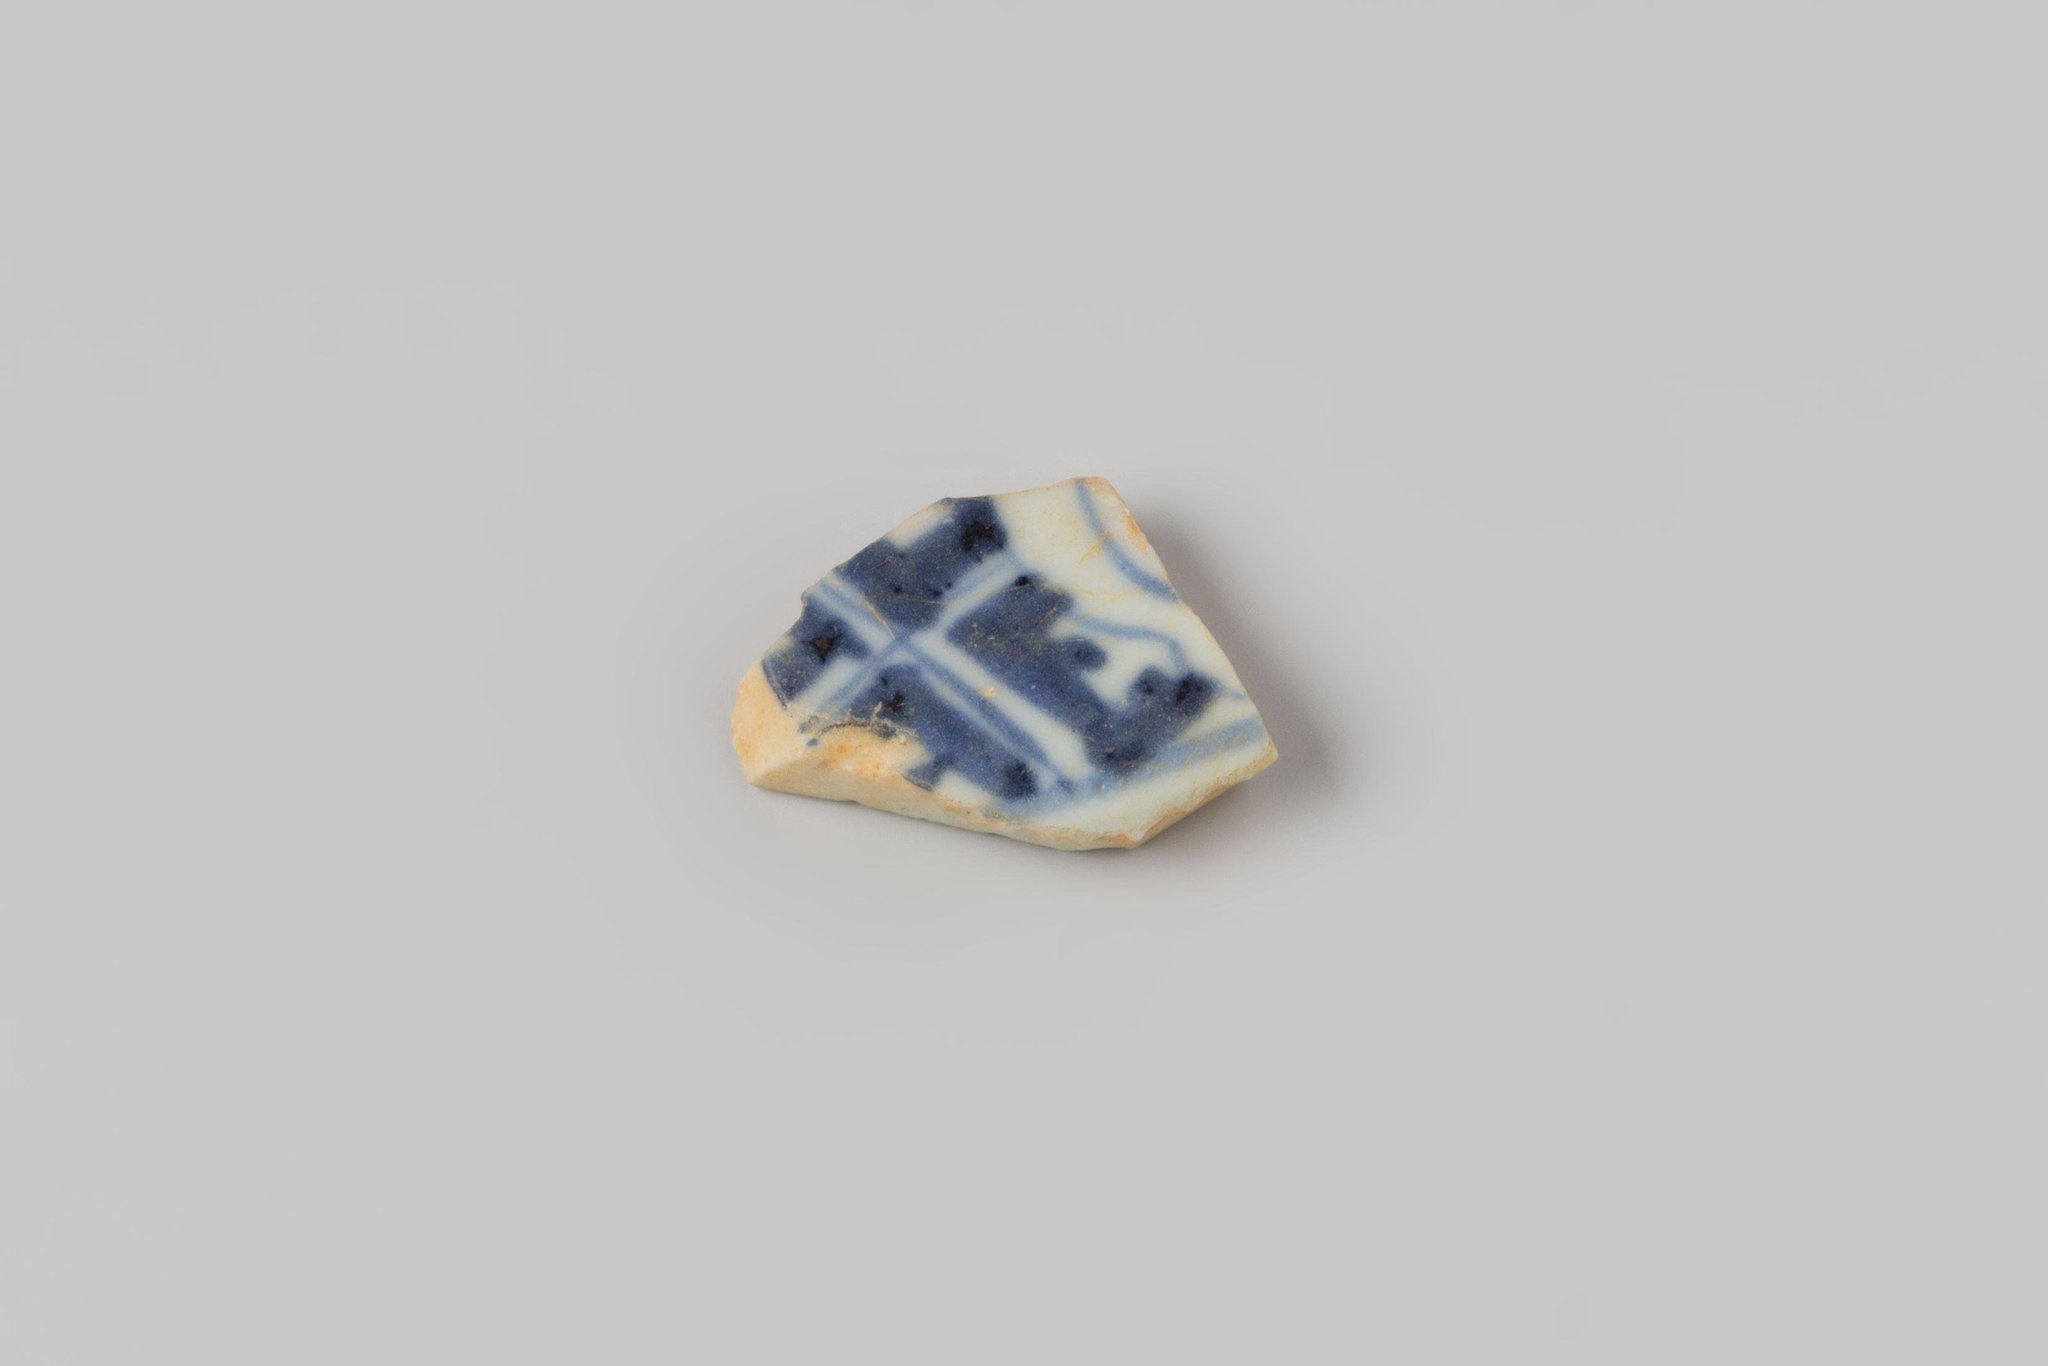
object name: plate dish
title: Scherf van een bord uit het wrak van de Oost-Indiëvaarder Hollandia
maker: Anonymous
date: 1700-1743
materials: porcelain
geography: netherlands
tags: verenigde oostindische compagnie, hollandia (schip), annet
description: Porcelain, plate, type 2; fragm of base, sim. NG 1980-27H507.